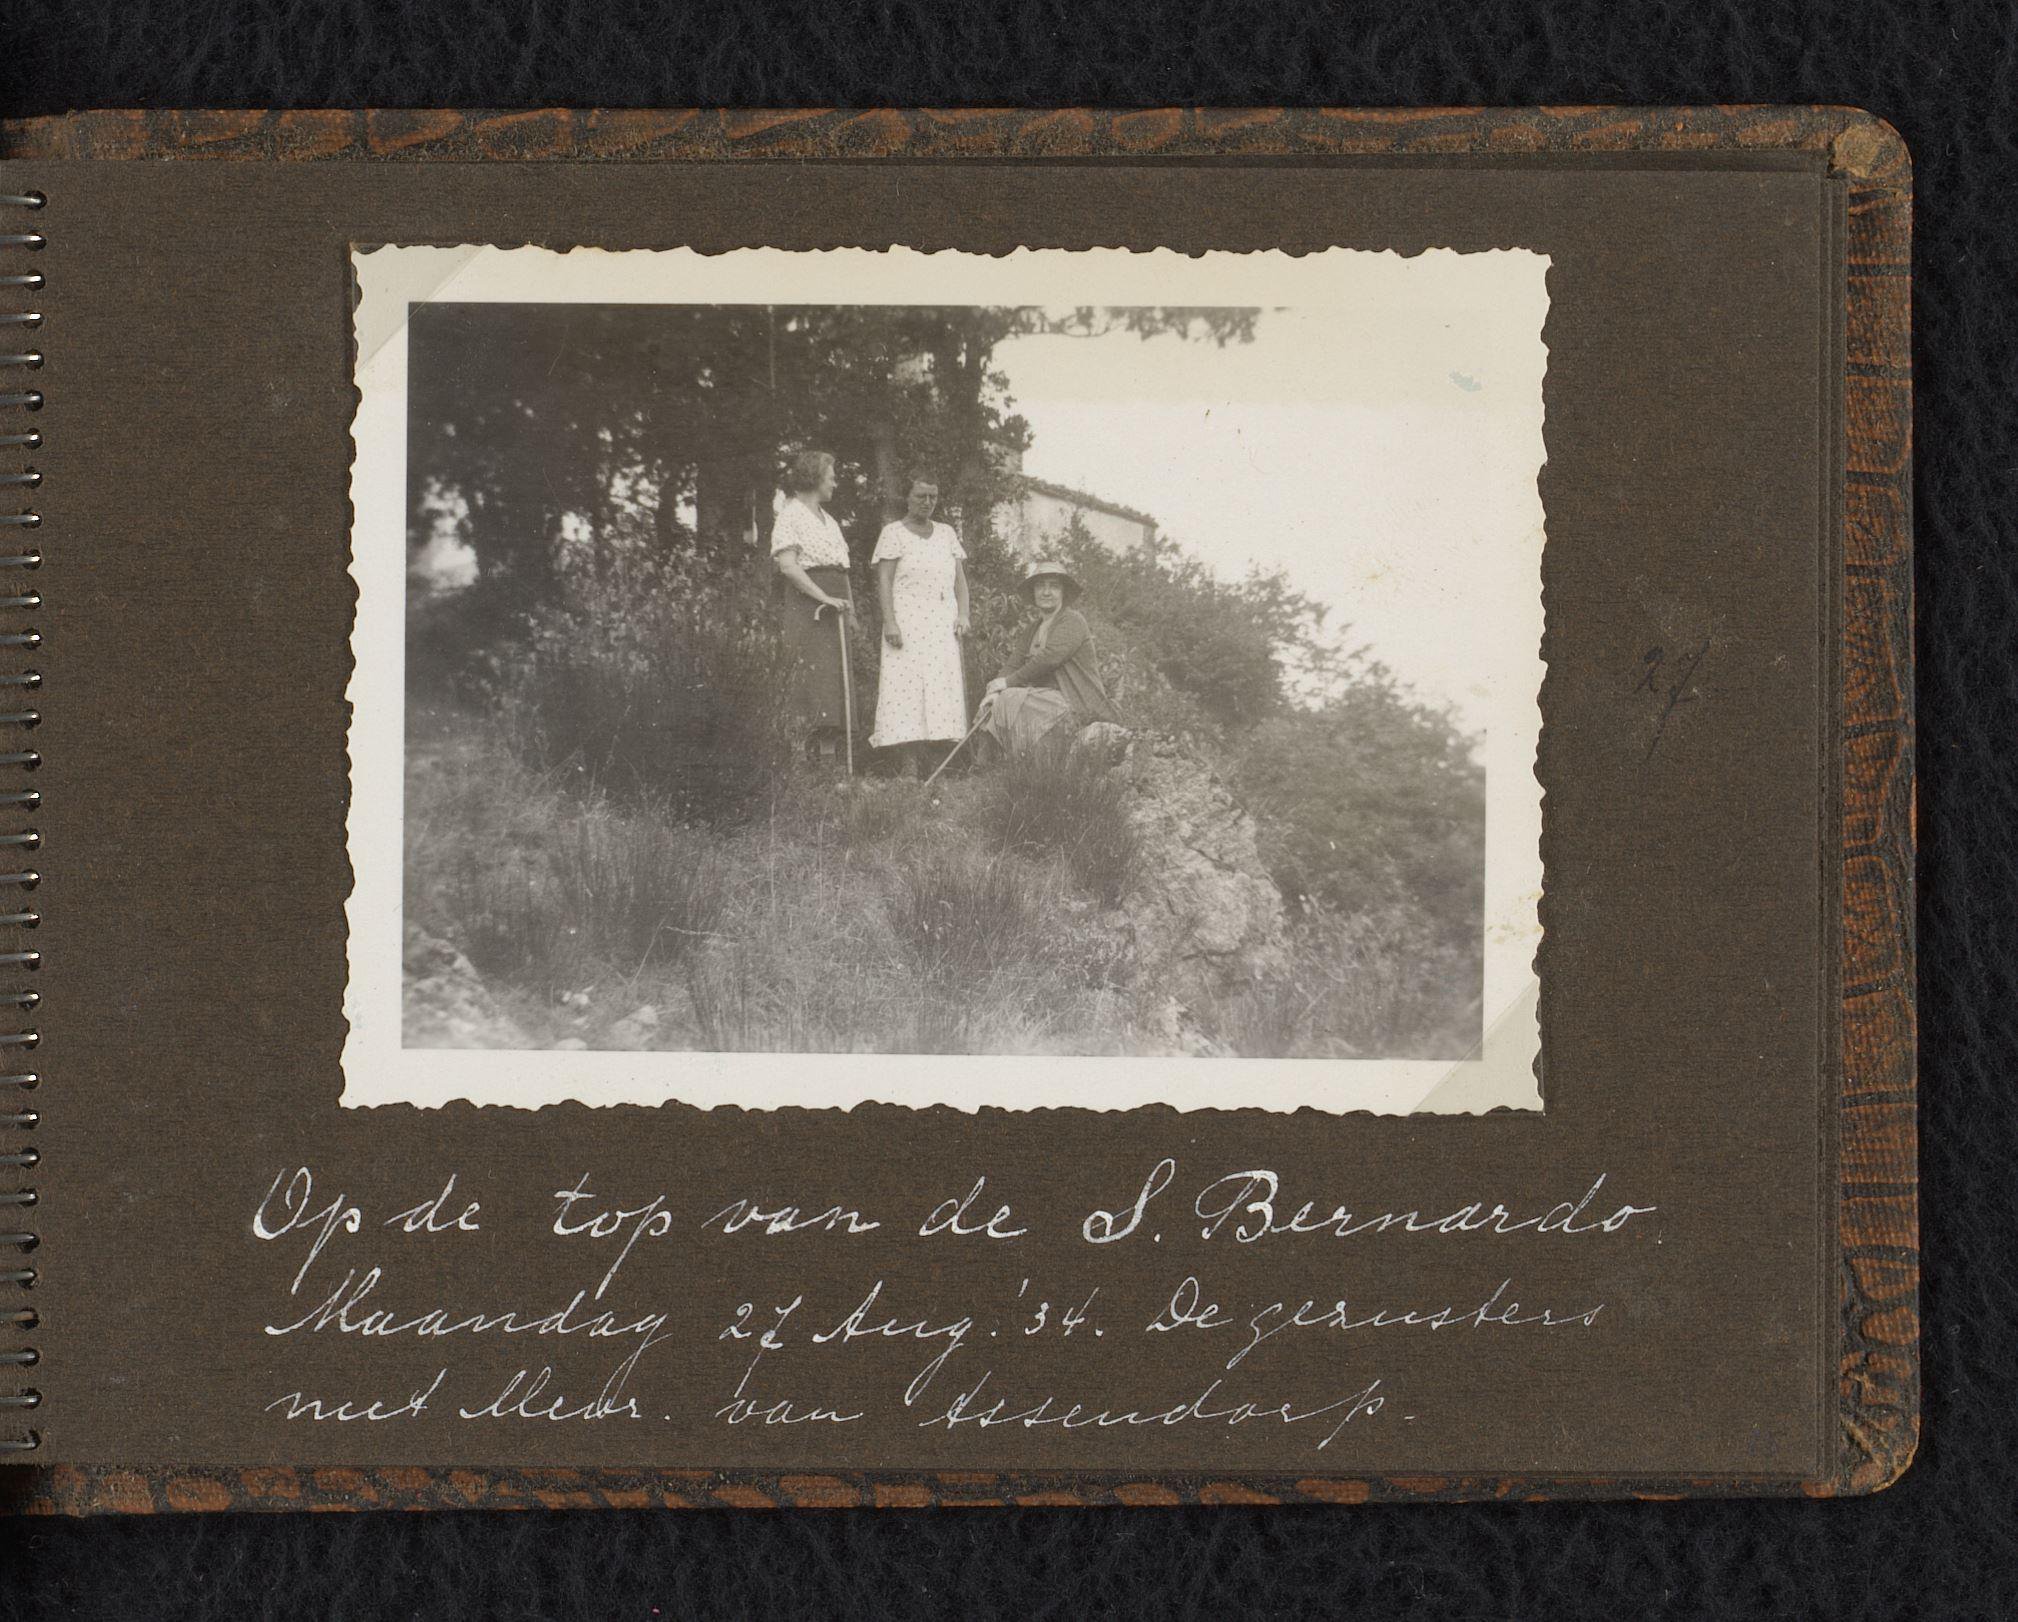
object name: photograph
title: Drie vrouwen op de top van de San Bernardo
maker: Anonymous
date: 1934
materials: paper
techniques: gelatin silver print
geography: collina di san bernardo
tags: adult woman, walking, hiking (recreation), mountain-top, peak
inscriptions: inscription: ‘Maandag 27 Aug. '34. De gezusters/ met Mevr. van Assendorp.’, number: ‘27’